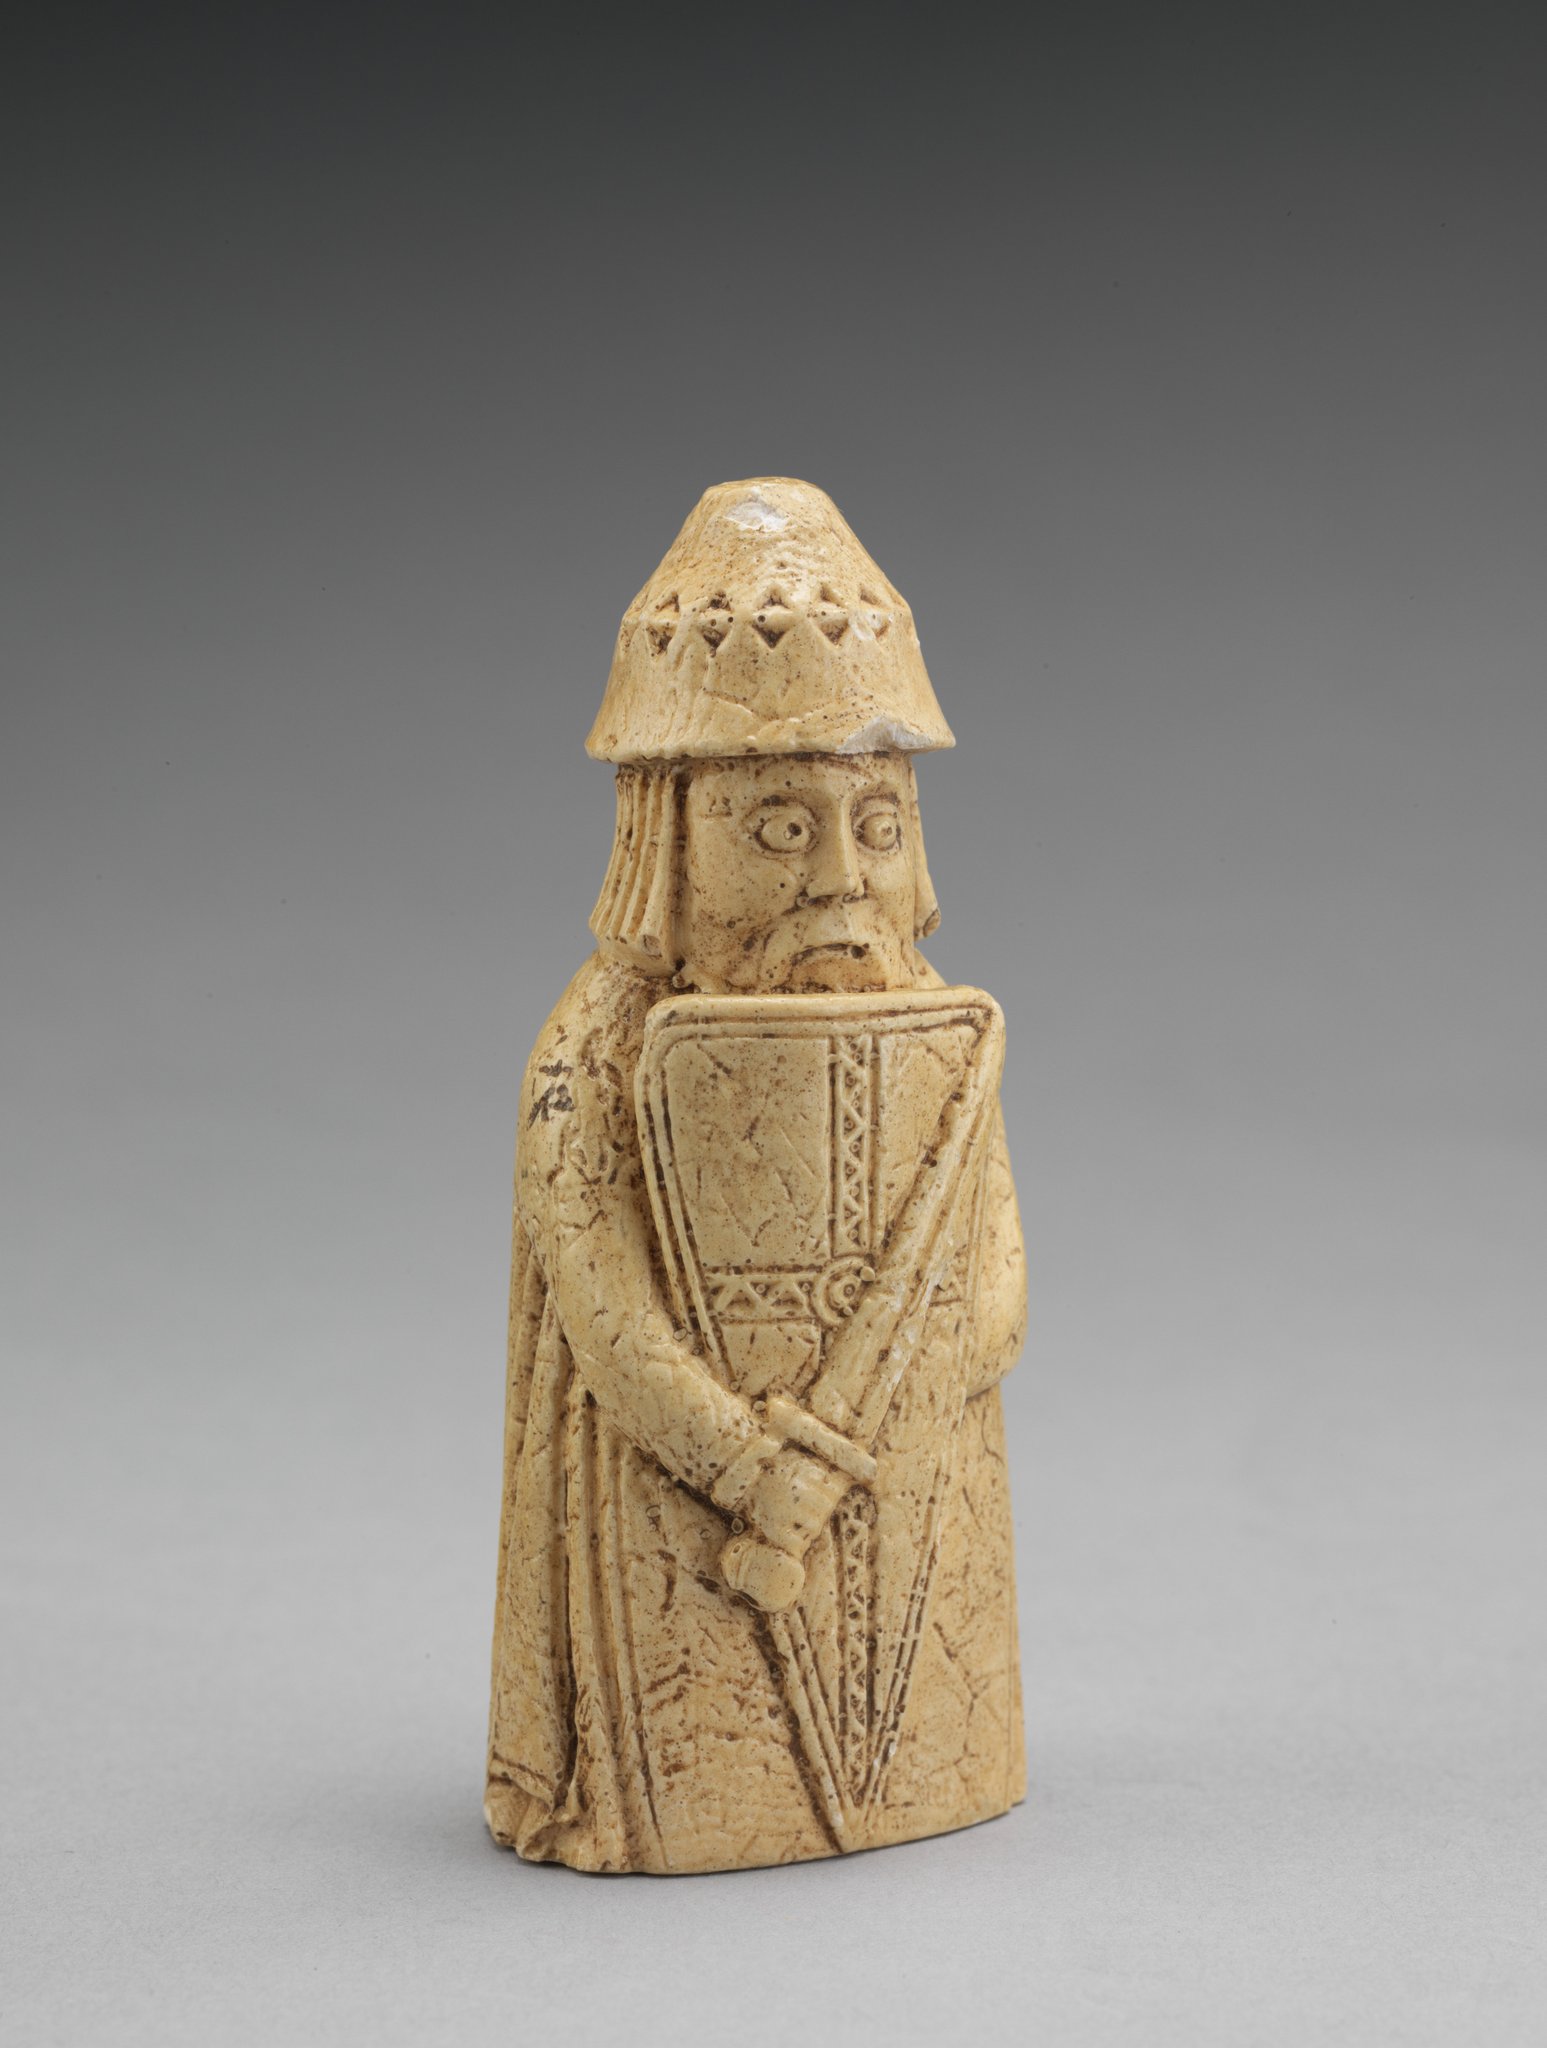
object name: chessman rook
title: Chessman (Rook)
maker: elkington & co.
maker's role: manufacturer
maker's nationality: british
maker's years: 1829-1963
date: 1870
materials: plaster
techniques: painting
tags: men,chess